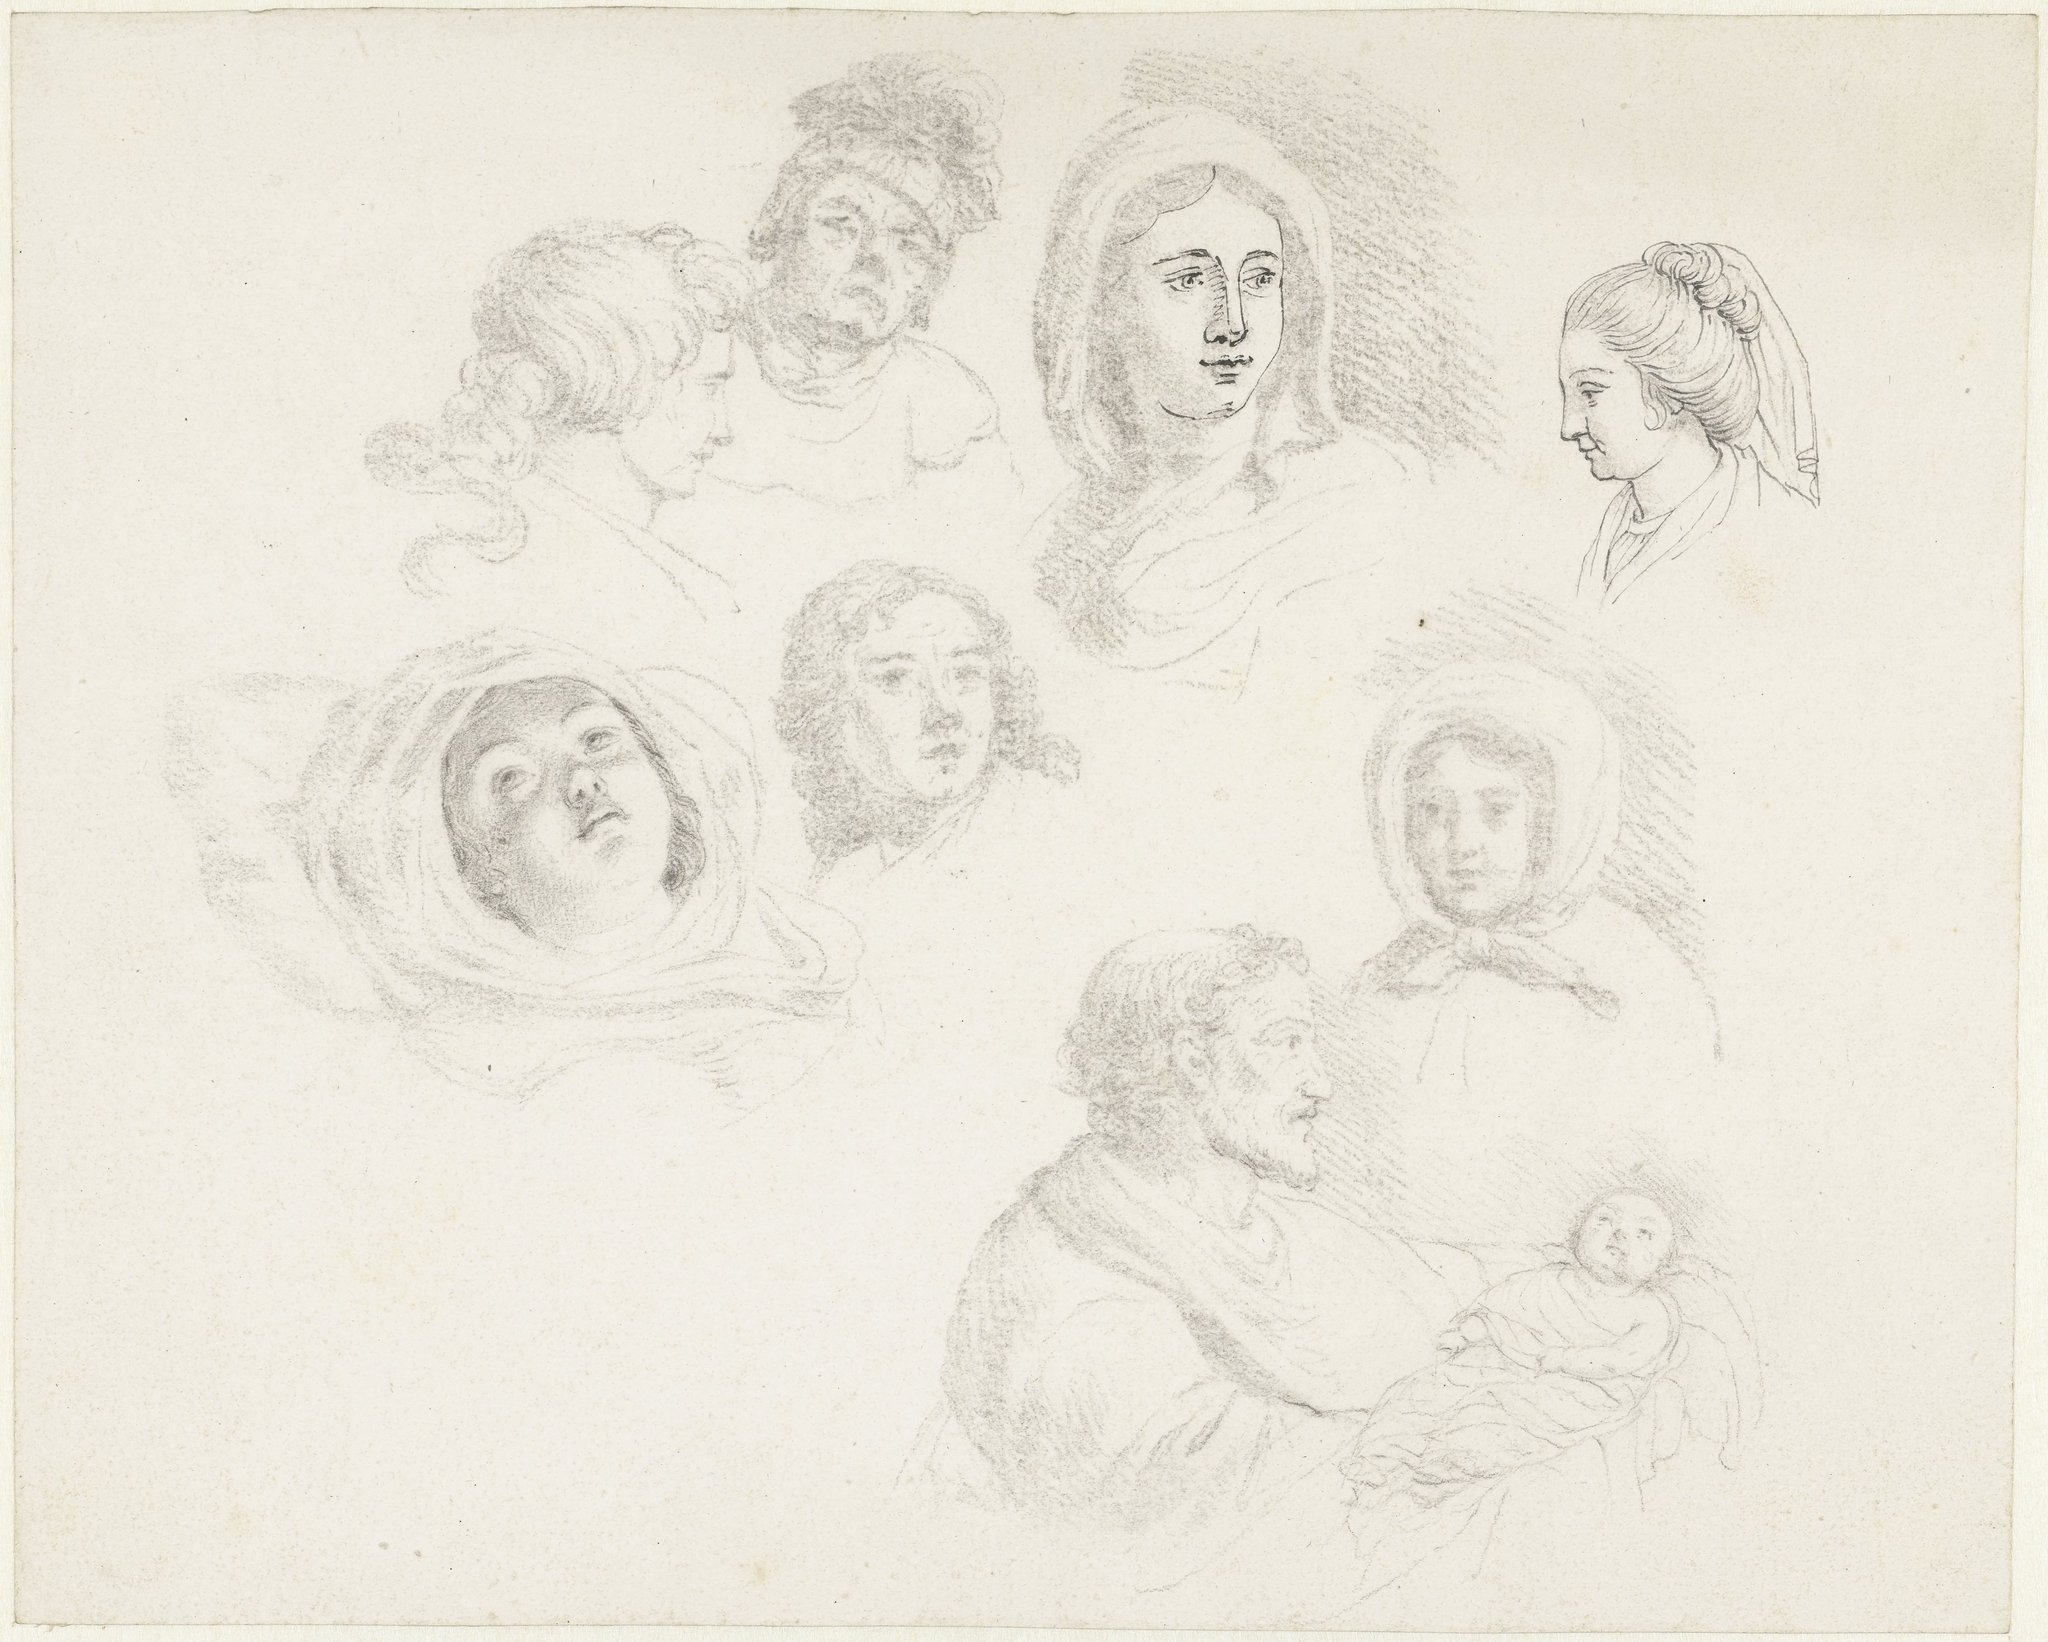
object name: drawing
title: Verschillende studies van hoofden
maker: jordanus hoorn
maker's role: draughtsman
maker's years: 1753-1833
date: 1763-1833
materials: chalk, ink, paper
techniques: pen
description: Schetsblad met verschillende studies van hoofden.